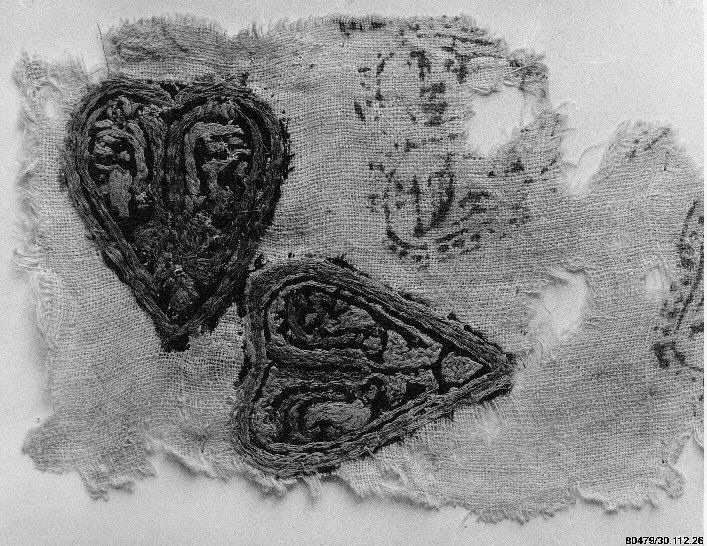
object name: textile fragment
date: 1201-1300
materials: linen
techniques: embroidery, printing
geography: egypt